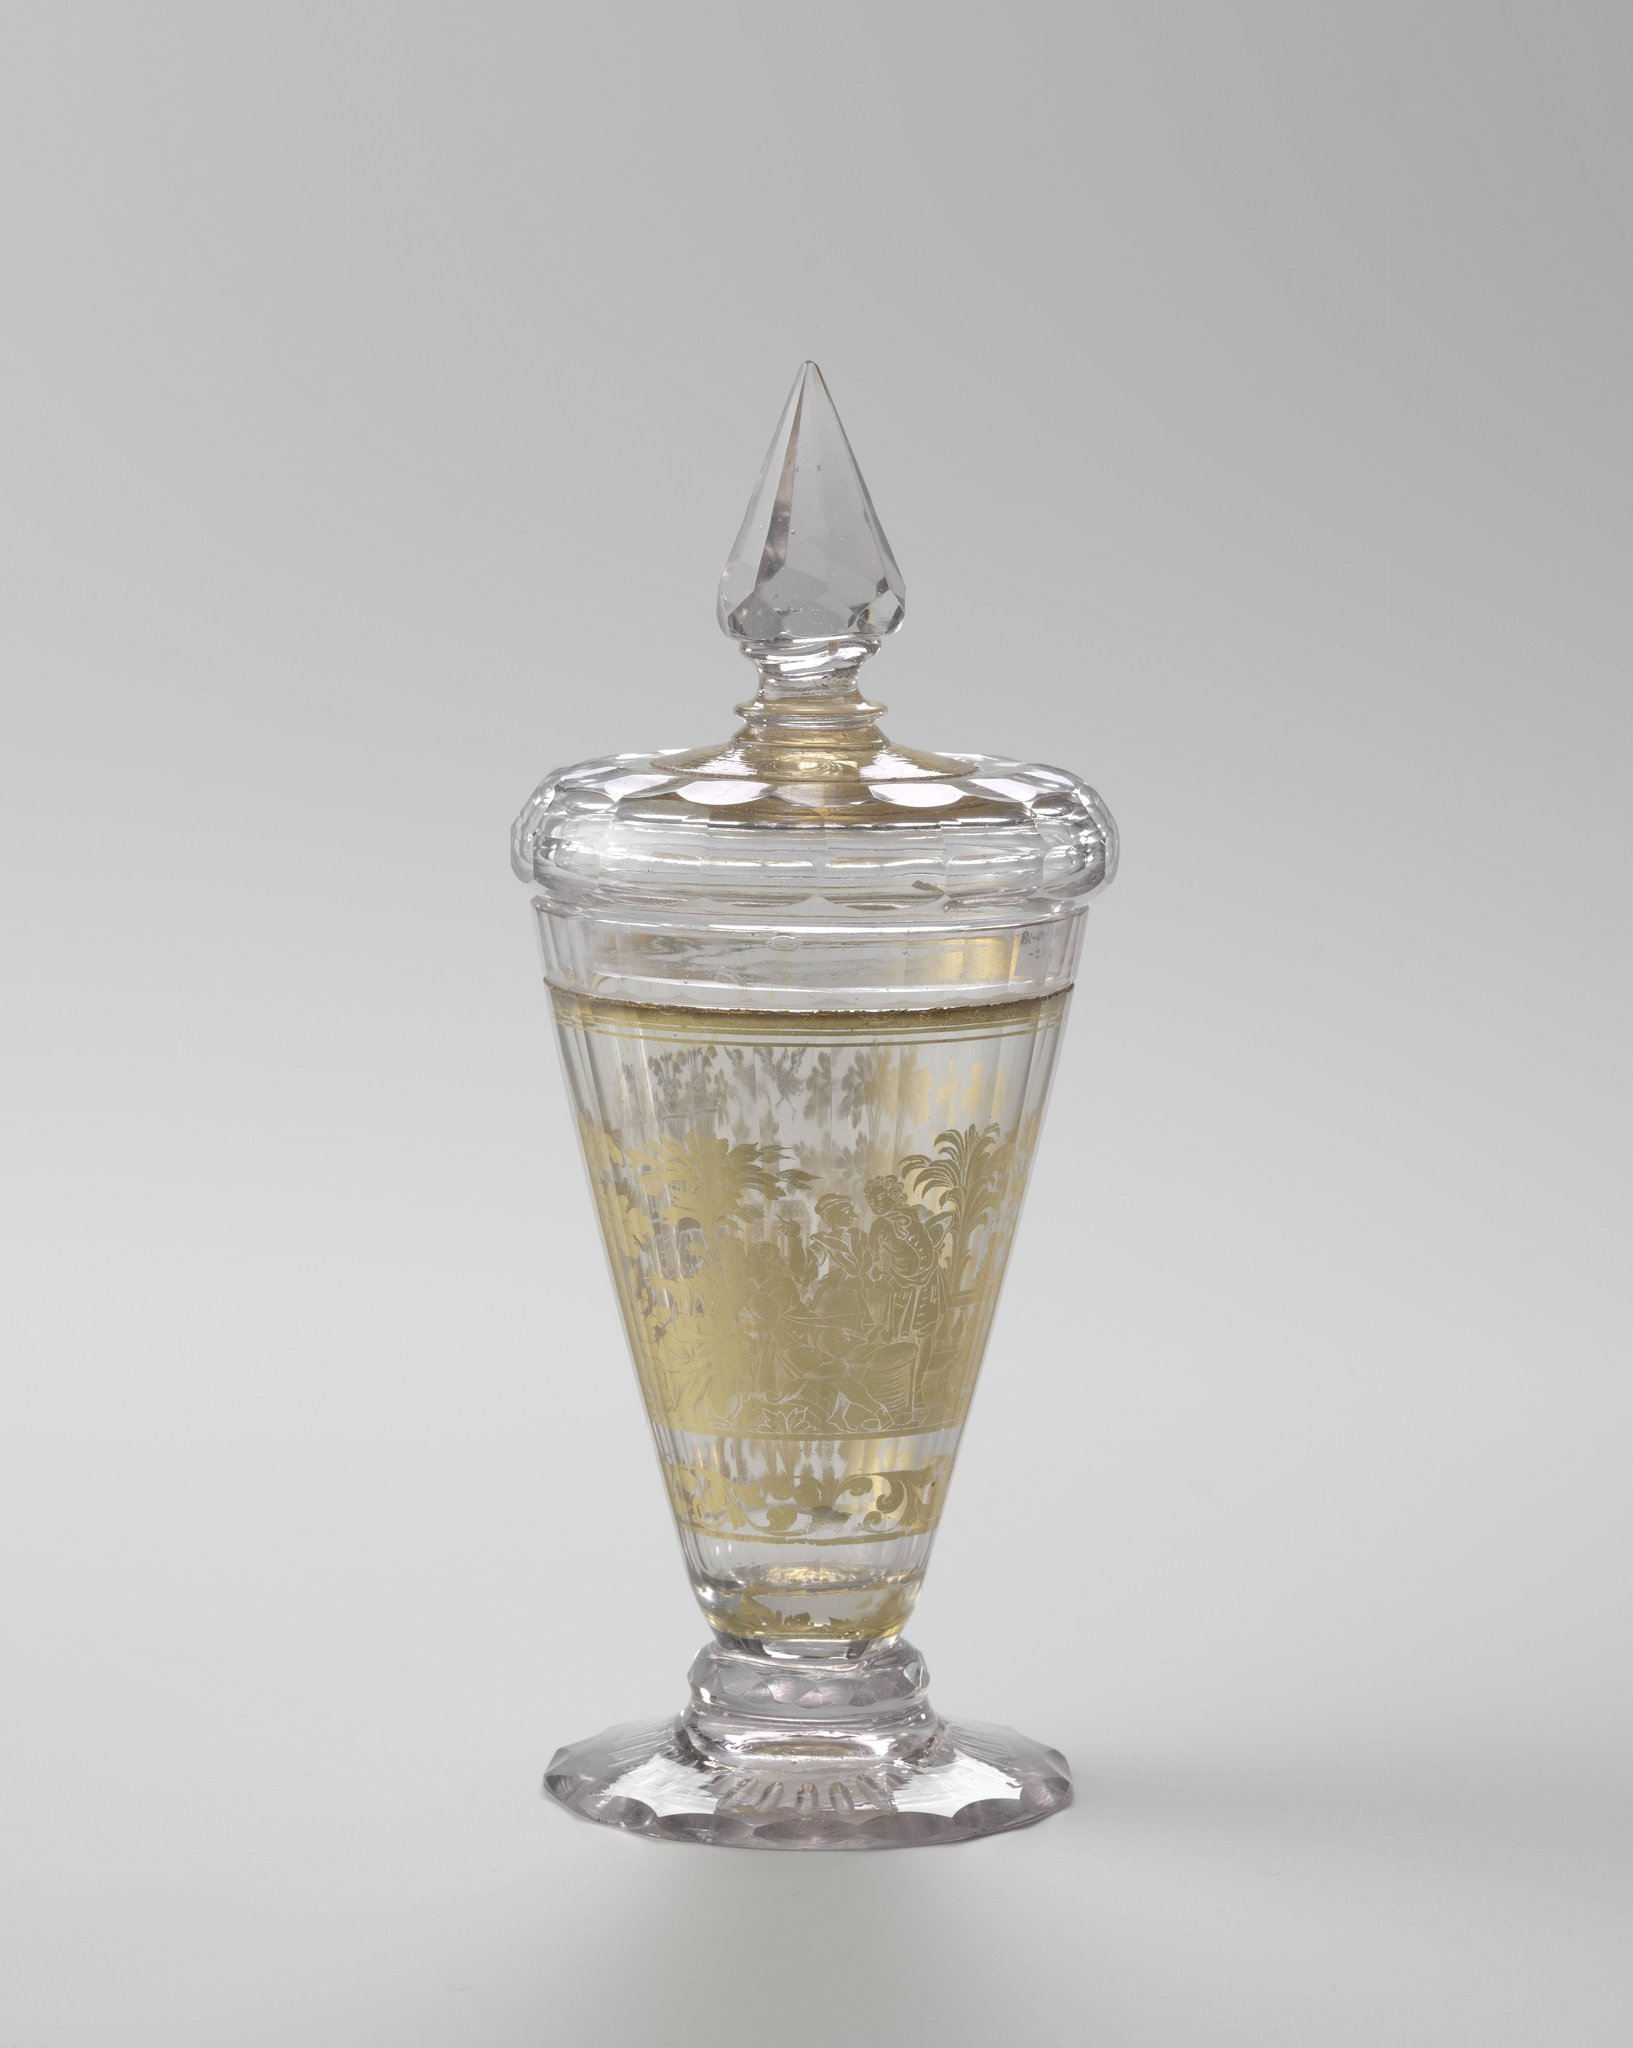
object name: lid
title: Deksel van Zwischengoldglas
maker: Anonymous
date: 1720-1740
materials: glass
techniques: glassblowing, grinding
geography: bohemia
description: In facetten geslepen deksel met puntige, eveneens gefacetteerde knop. In het deksel een medaillon van ruiten omgeven door een gestileerde bladrank. Met bijbehorende beker (BK-NM-10754-269-1).